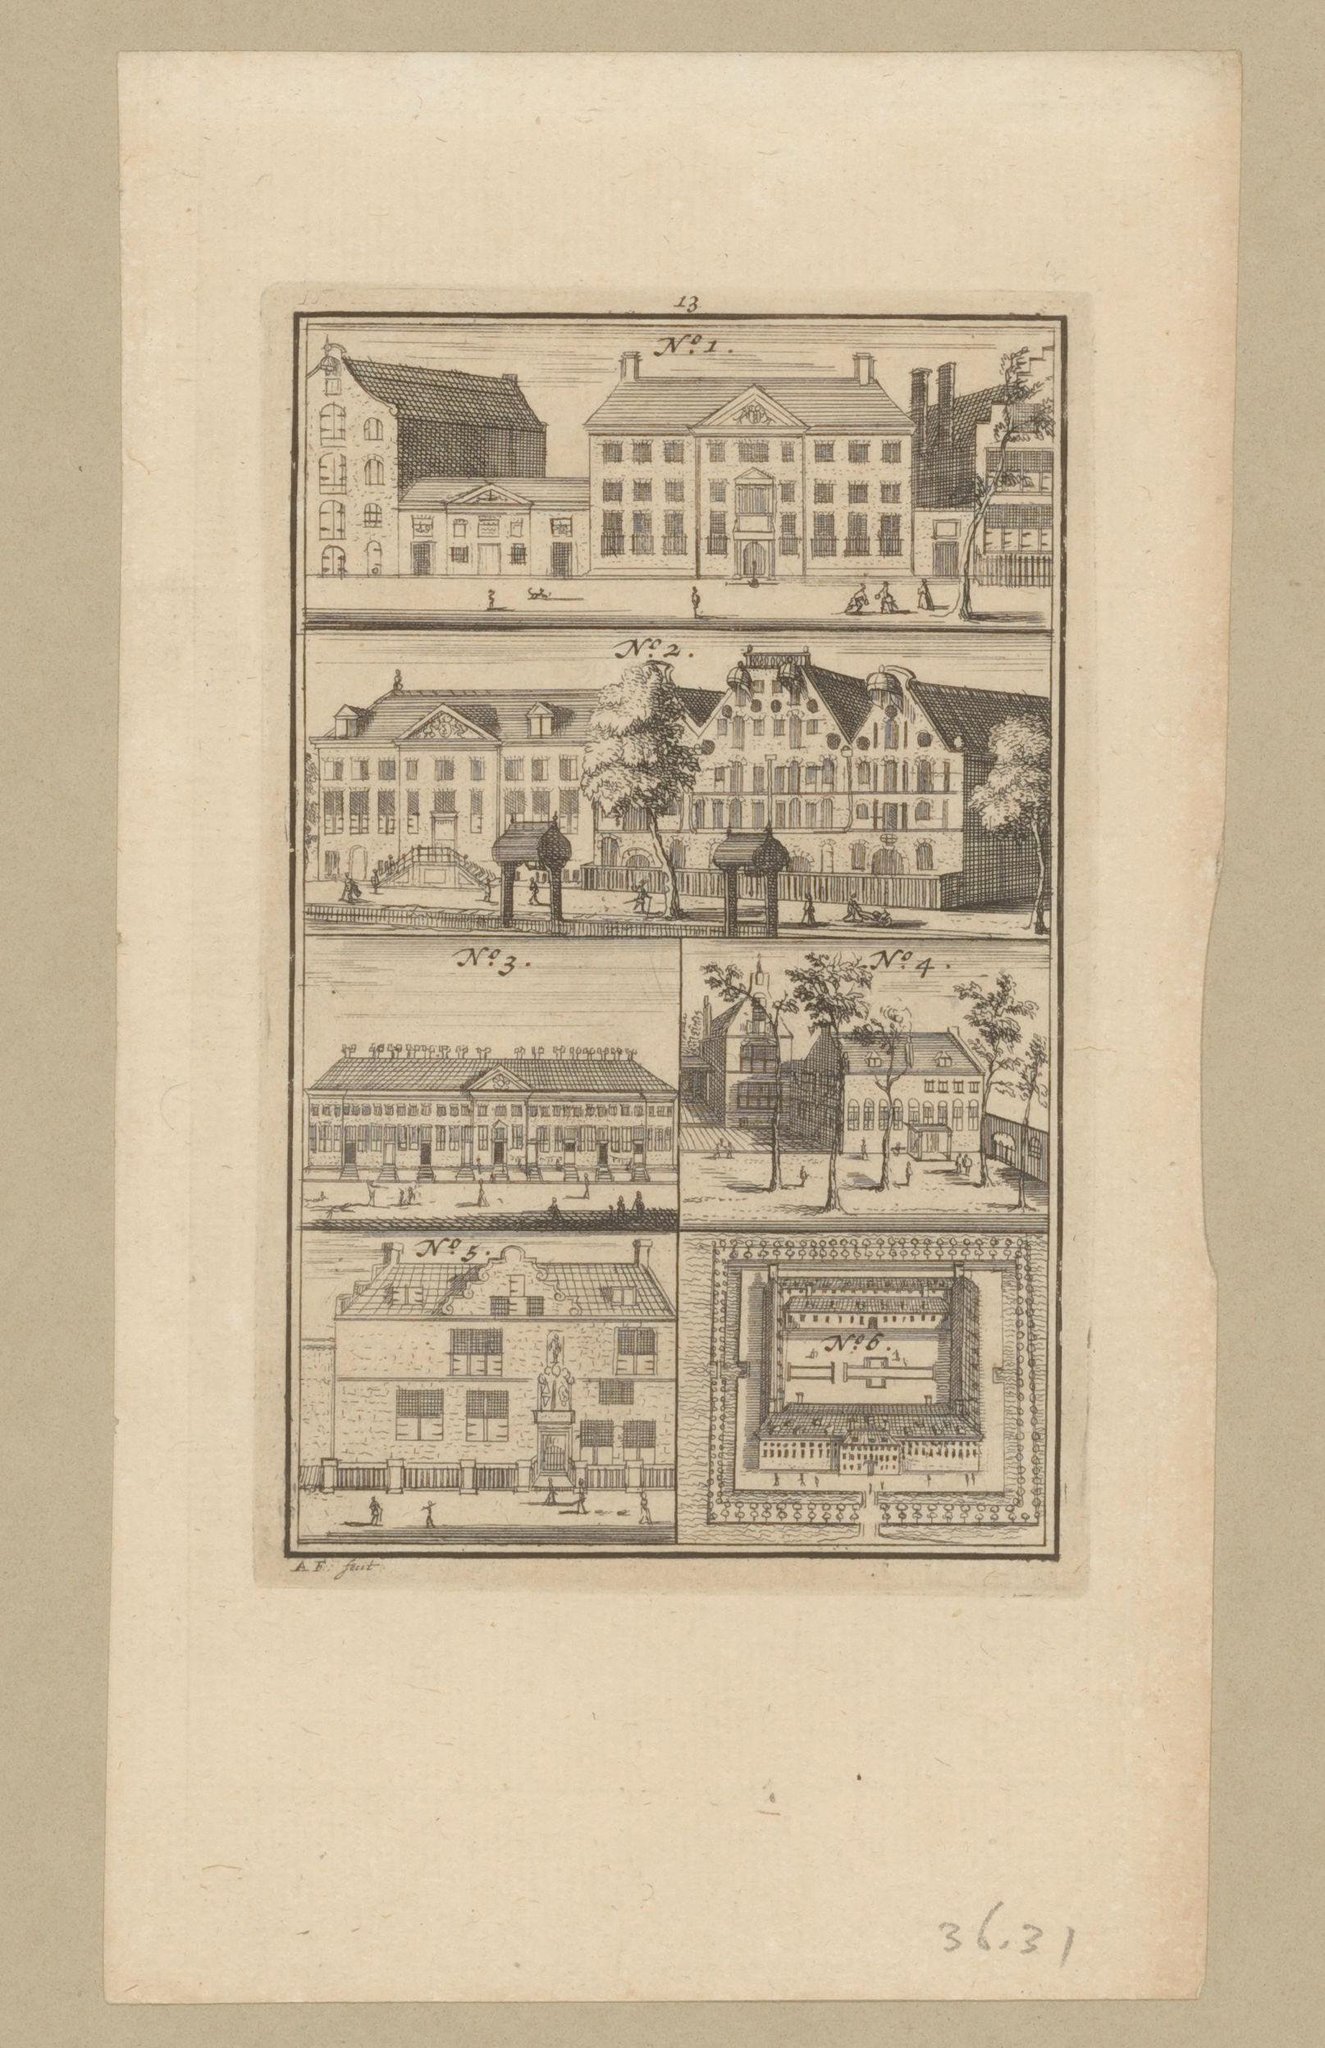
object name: print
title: Zes verschillende gebouwen te Amsterdam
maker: anna folkema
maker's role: draughtsman, print maker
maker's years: 1695-1768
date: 1723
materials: paper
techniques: engraving, etching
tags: civic architecture; edifices; dwellings, plague, amsterdam, dolhuis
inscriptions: collector's mark: Lugt 1641b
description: Zes genummerde gebouwen te Amsterdam: Nieuwezijds Huiszittenhuis, Oudezijds Huiszittenhuis, Karthuizer Weduwenhof, Leprozenhuis, Dolhuis, Buitengasthuis. De gebouwen zijn op het bijbehorende tekstblad voorzien van toelichting. Bovenaan genummerd: 13. Onderwerpsrubriek binnen de Atlas Amsterdam: Armwezen en liefdadige instellingen: I. Stadsinrichtingen: Verzamelbladen.